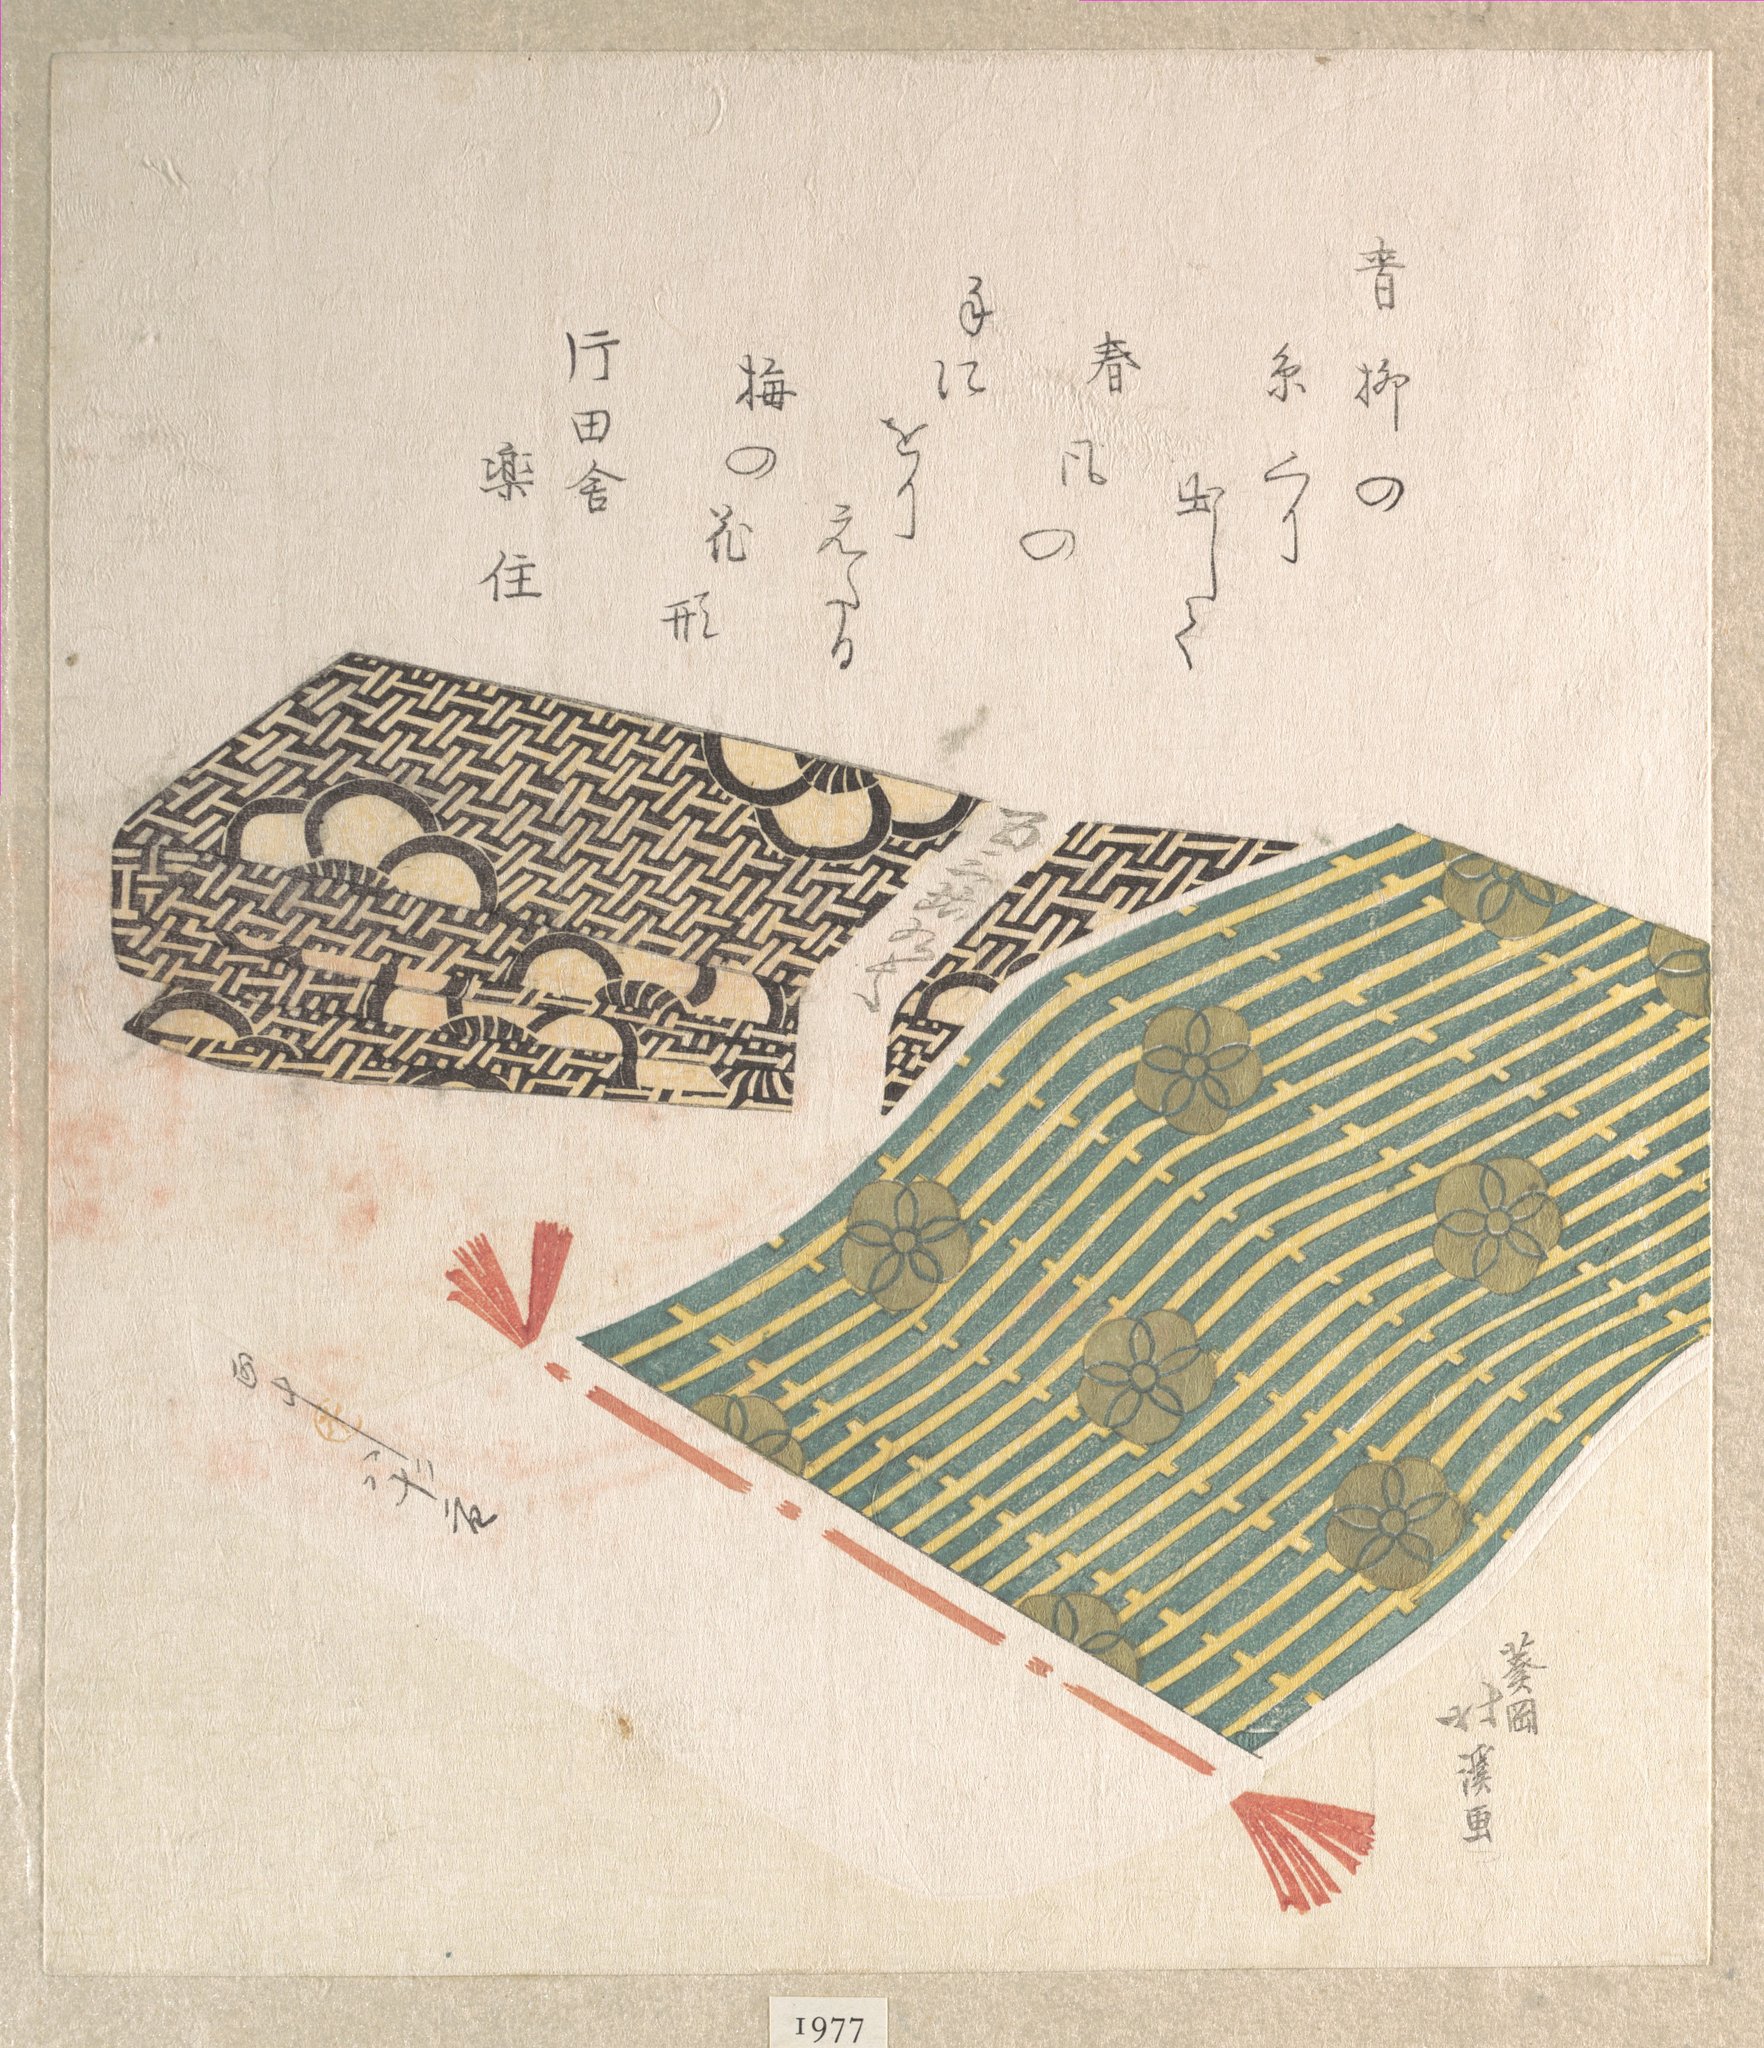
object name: print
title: Pattern of Plum Blossom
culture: japanese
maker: totoya hokkei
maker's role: artist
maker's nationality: japanese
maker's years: 1780-1850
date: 1815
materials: ink, paper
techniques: surimono, woodblock print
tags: flowers